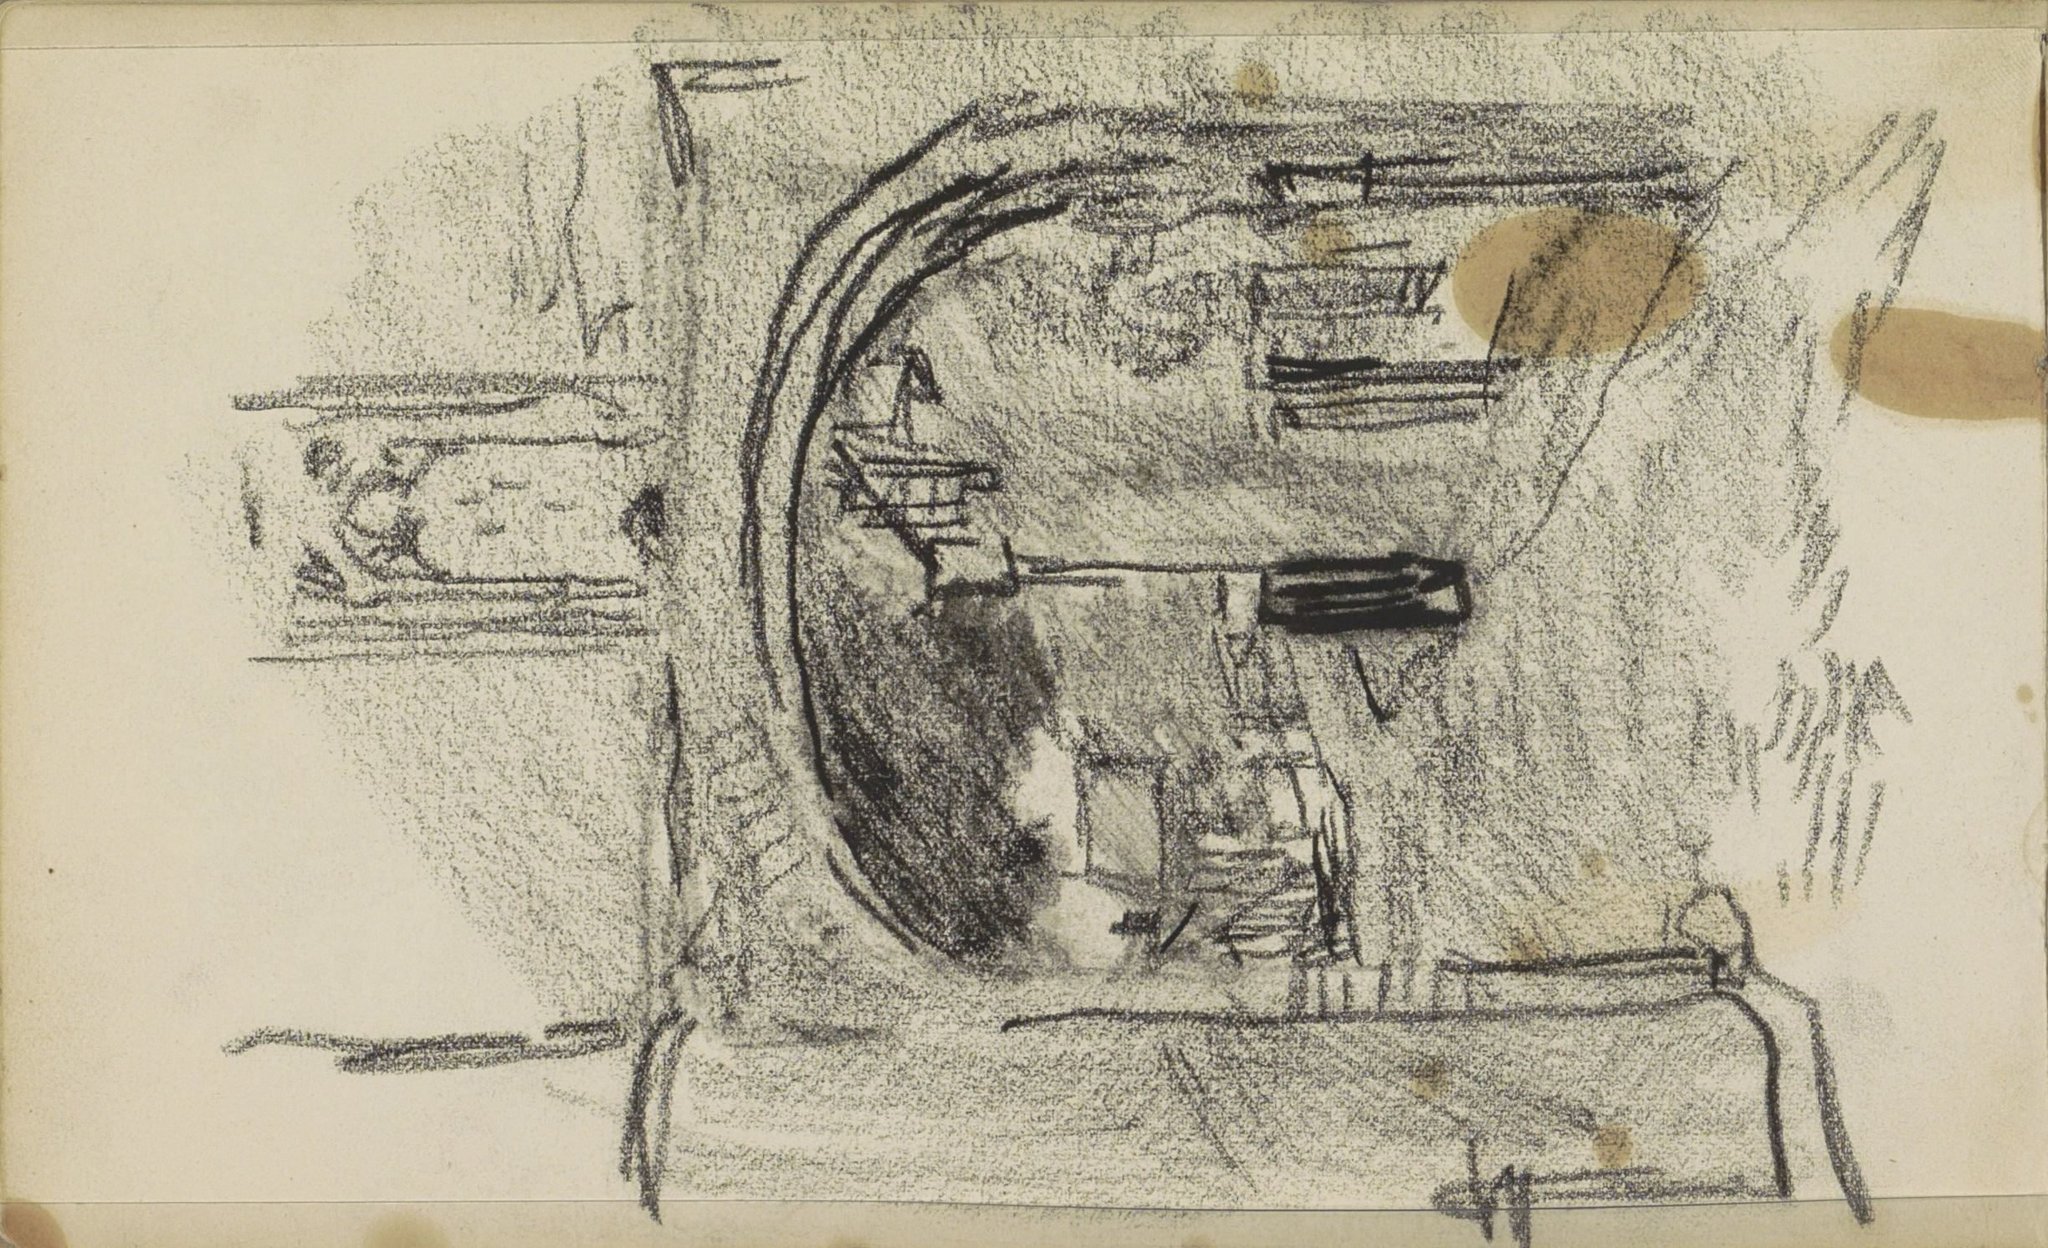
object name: sketchbook leaf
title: Straat gezien door een poort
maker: jozef israëls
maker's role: draughtsman, painter, print maker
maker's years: 1824-1911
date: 1834-1911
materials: chalk, paper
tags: gate, entrance, street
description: Blad 37 verso uit een schetsboek met 42 bladen.